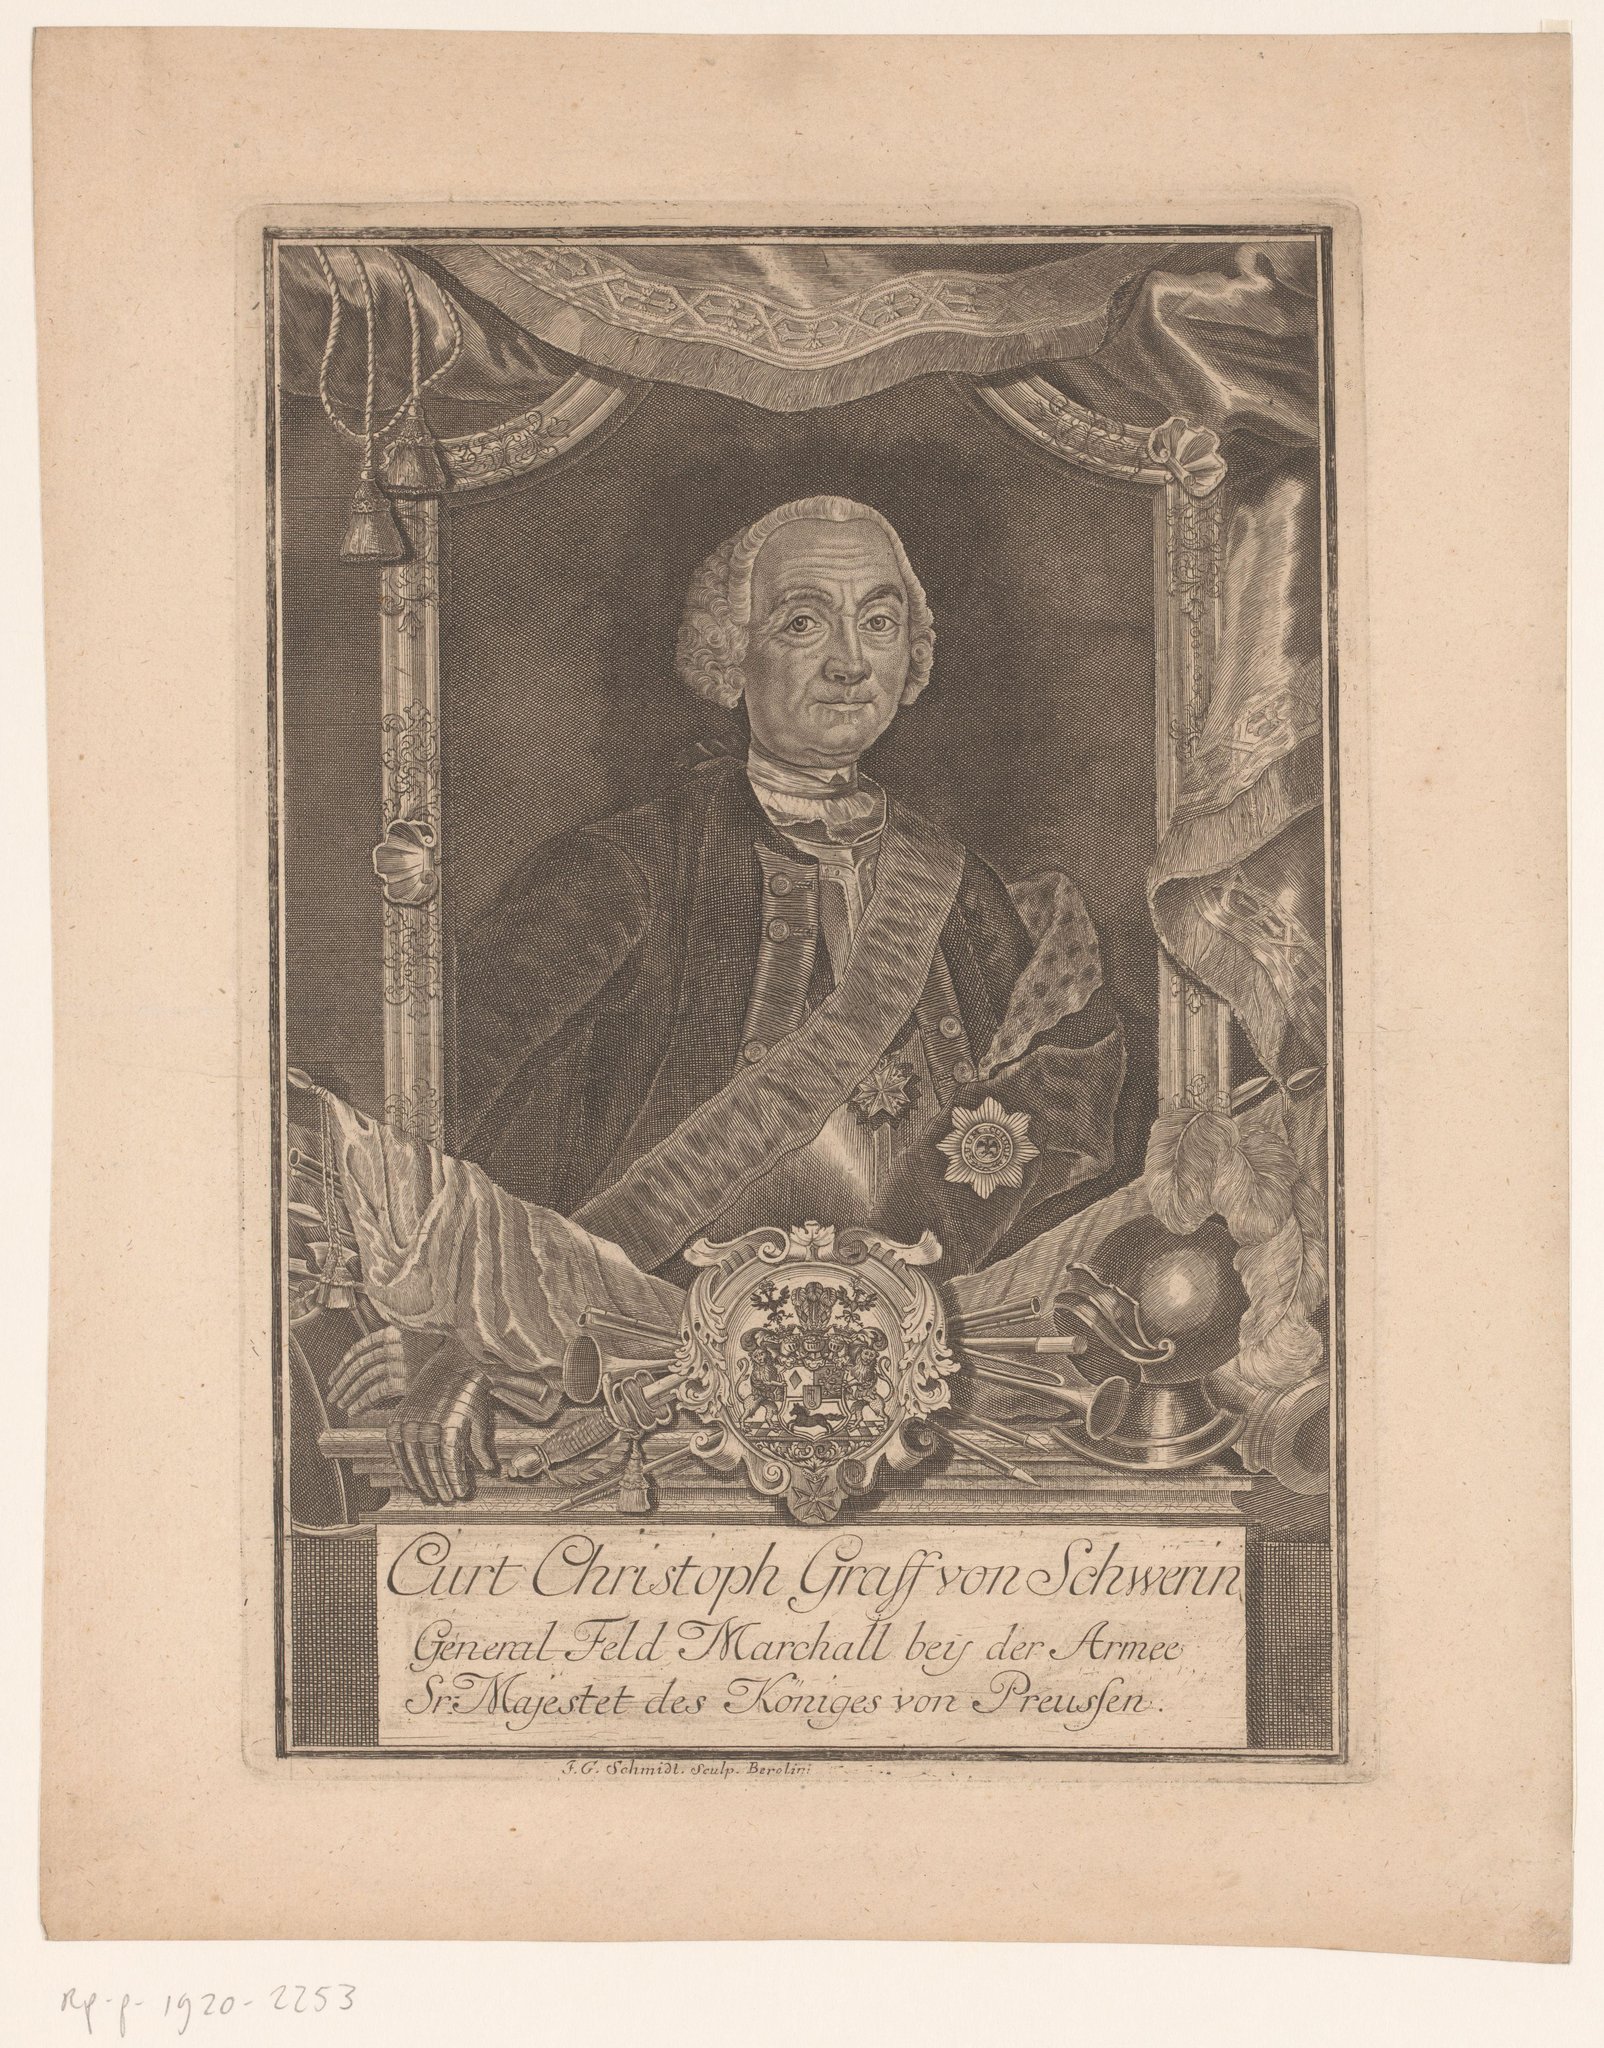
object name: print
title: Portret van Kurd Christoph von Schwerin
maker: johann georg schmidt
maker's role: print maker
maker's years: 1694-1767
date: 1704-1765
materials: paper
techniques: engraving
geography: berlin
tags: prague, historical persons, armorial bearing, heraldry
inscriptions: collector's mark: Lugt 2228